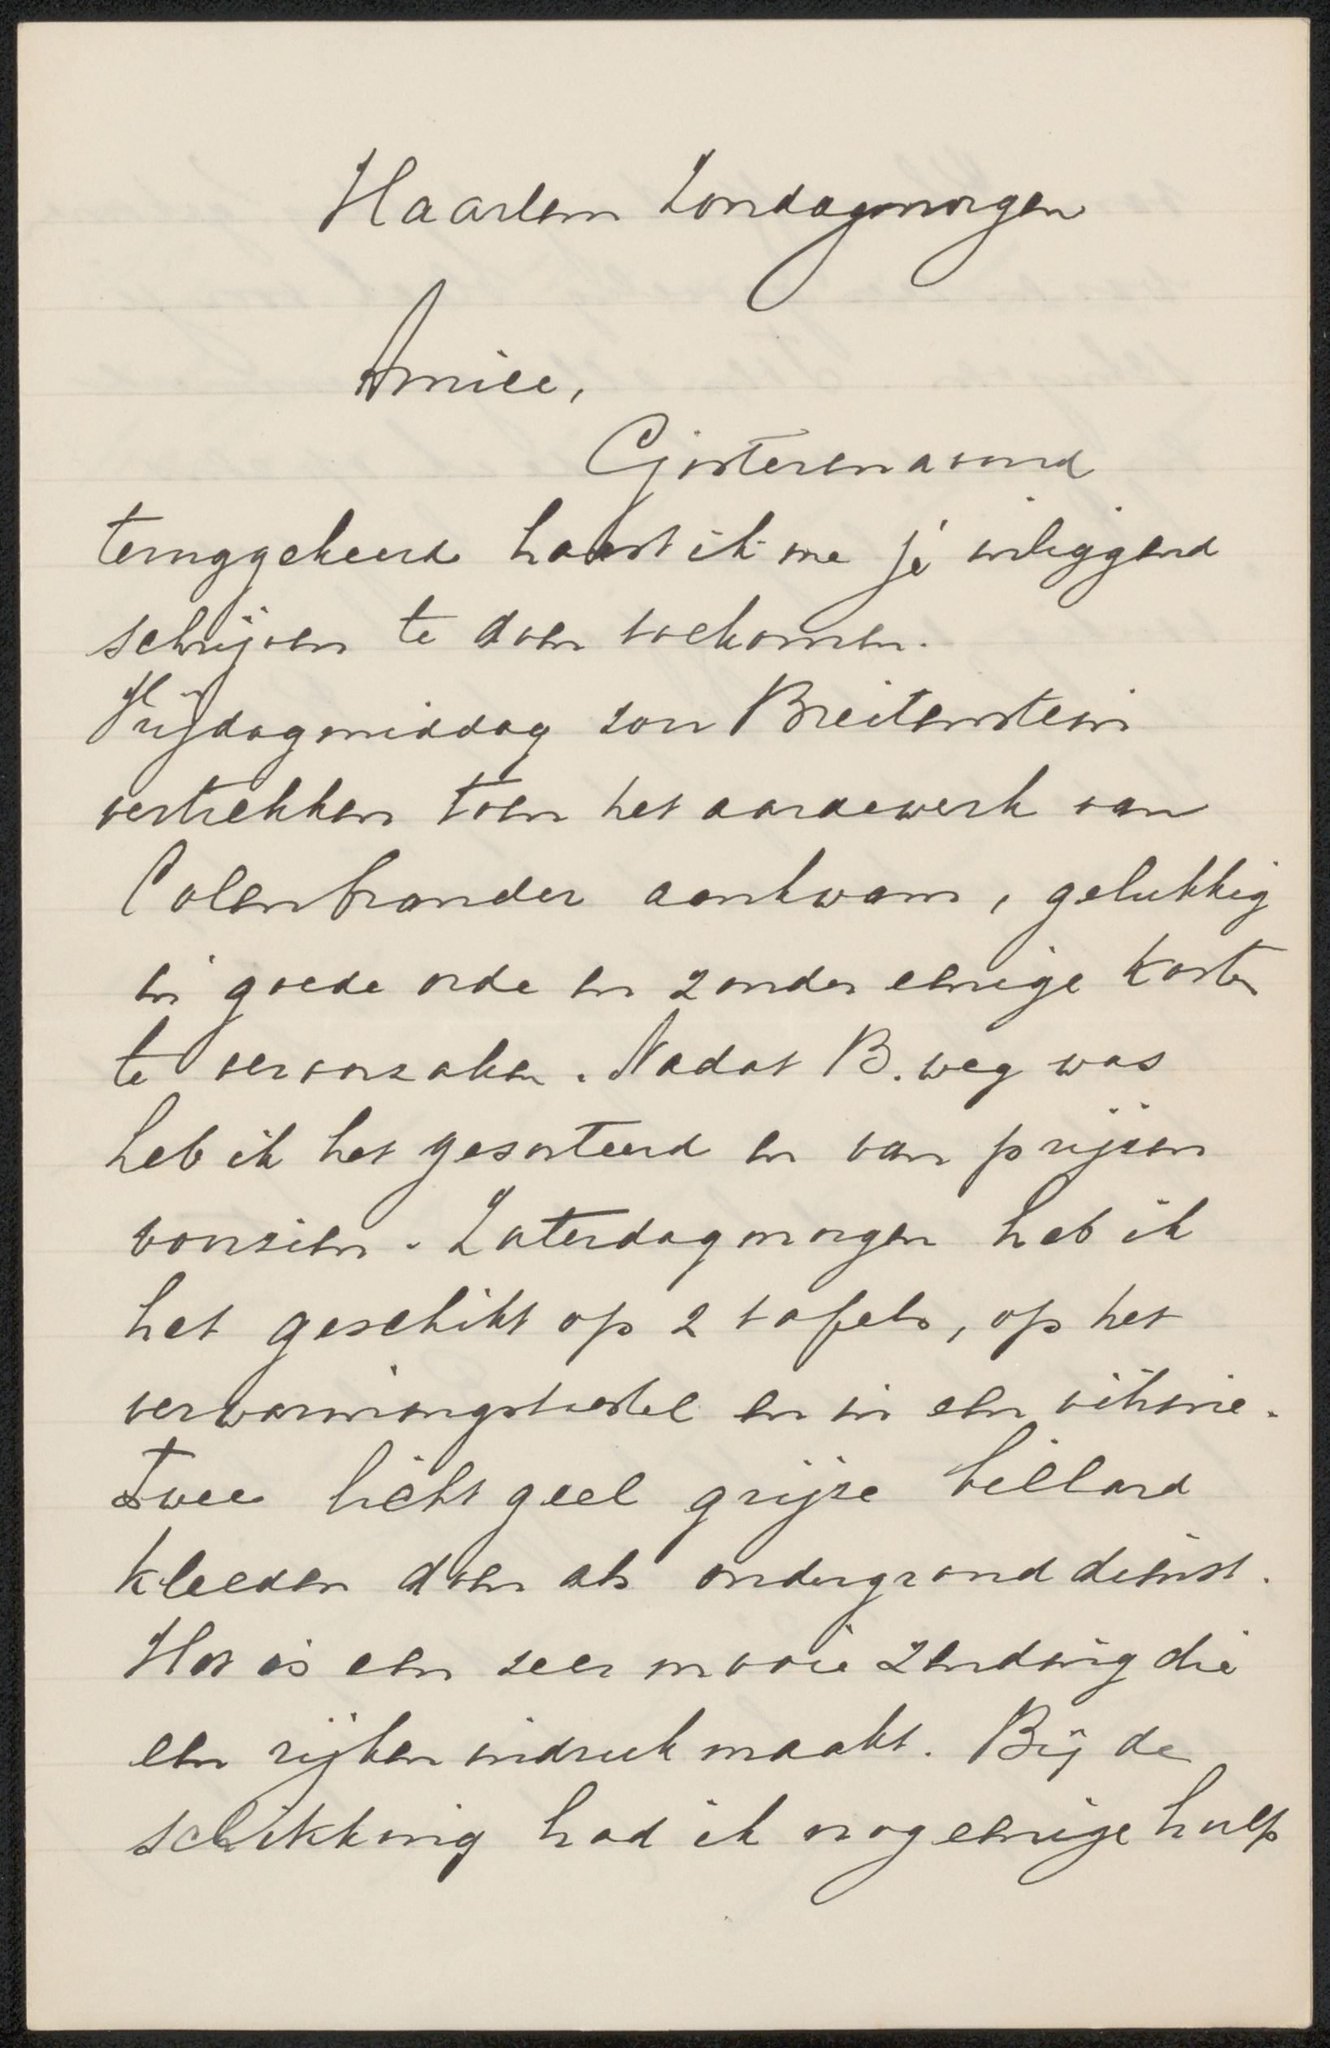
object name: letter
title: Brief aan Philip Zilcken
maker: anton l. koster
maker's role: draughtsman, painter, print maker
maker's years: 1859-1937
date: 1913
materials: ink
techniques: pen, writing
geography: haarlem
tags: fernand khnopff, theo colenbrander, carl august breitenstein, the hague, painter, print maker, draughtsman, willy sluiter, brussels, philippe wolfers, philip zilcken, money, antwerp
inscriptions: collector's mark: ‘RPK’, address: ‘A. L. KOSTER/ Spruitenboschstraat 19/ Haarlem.’